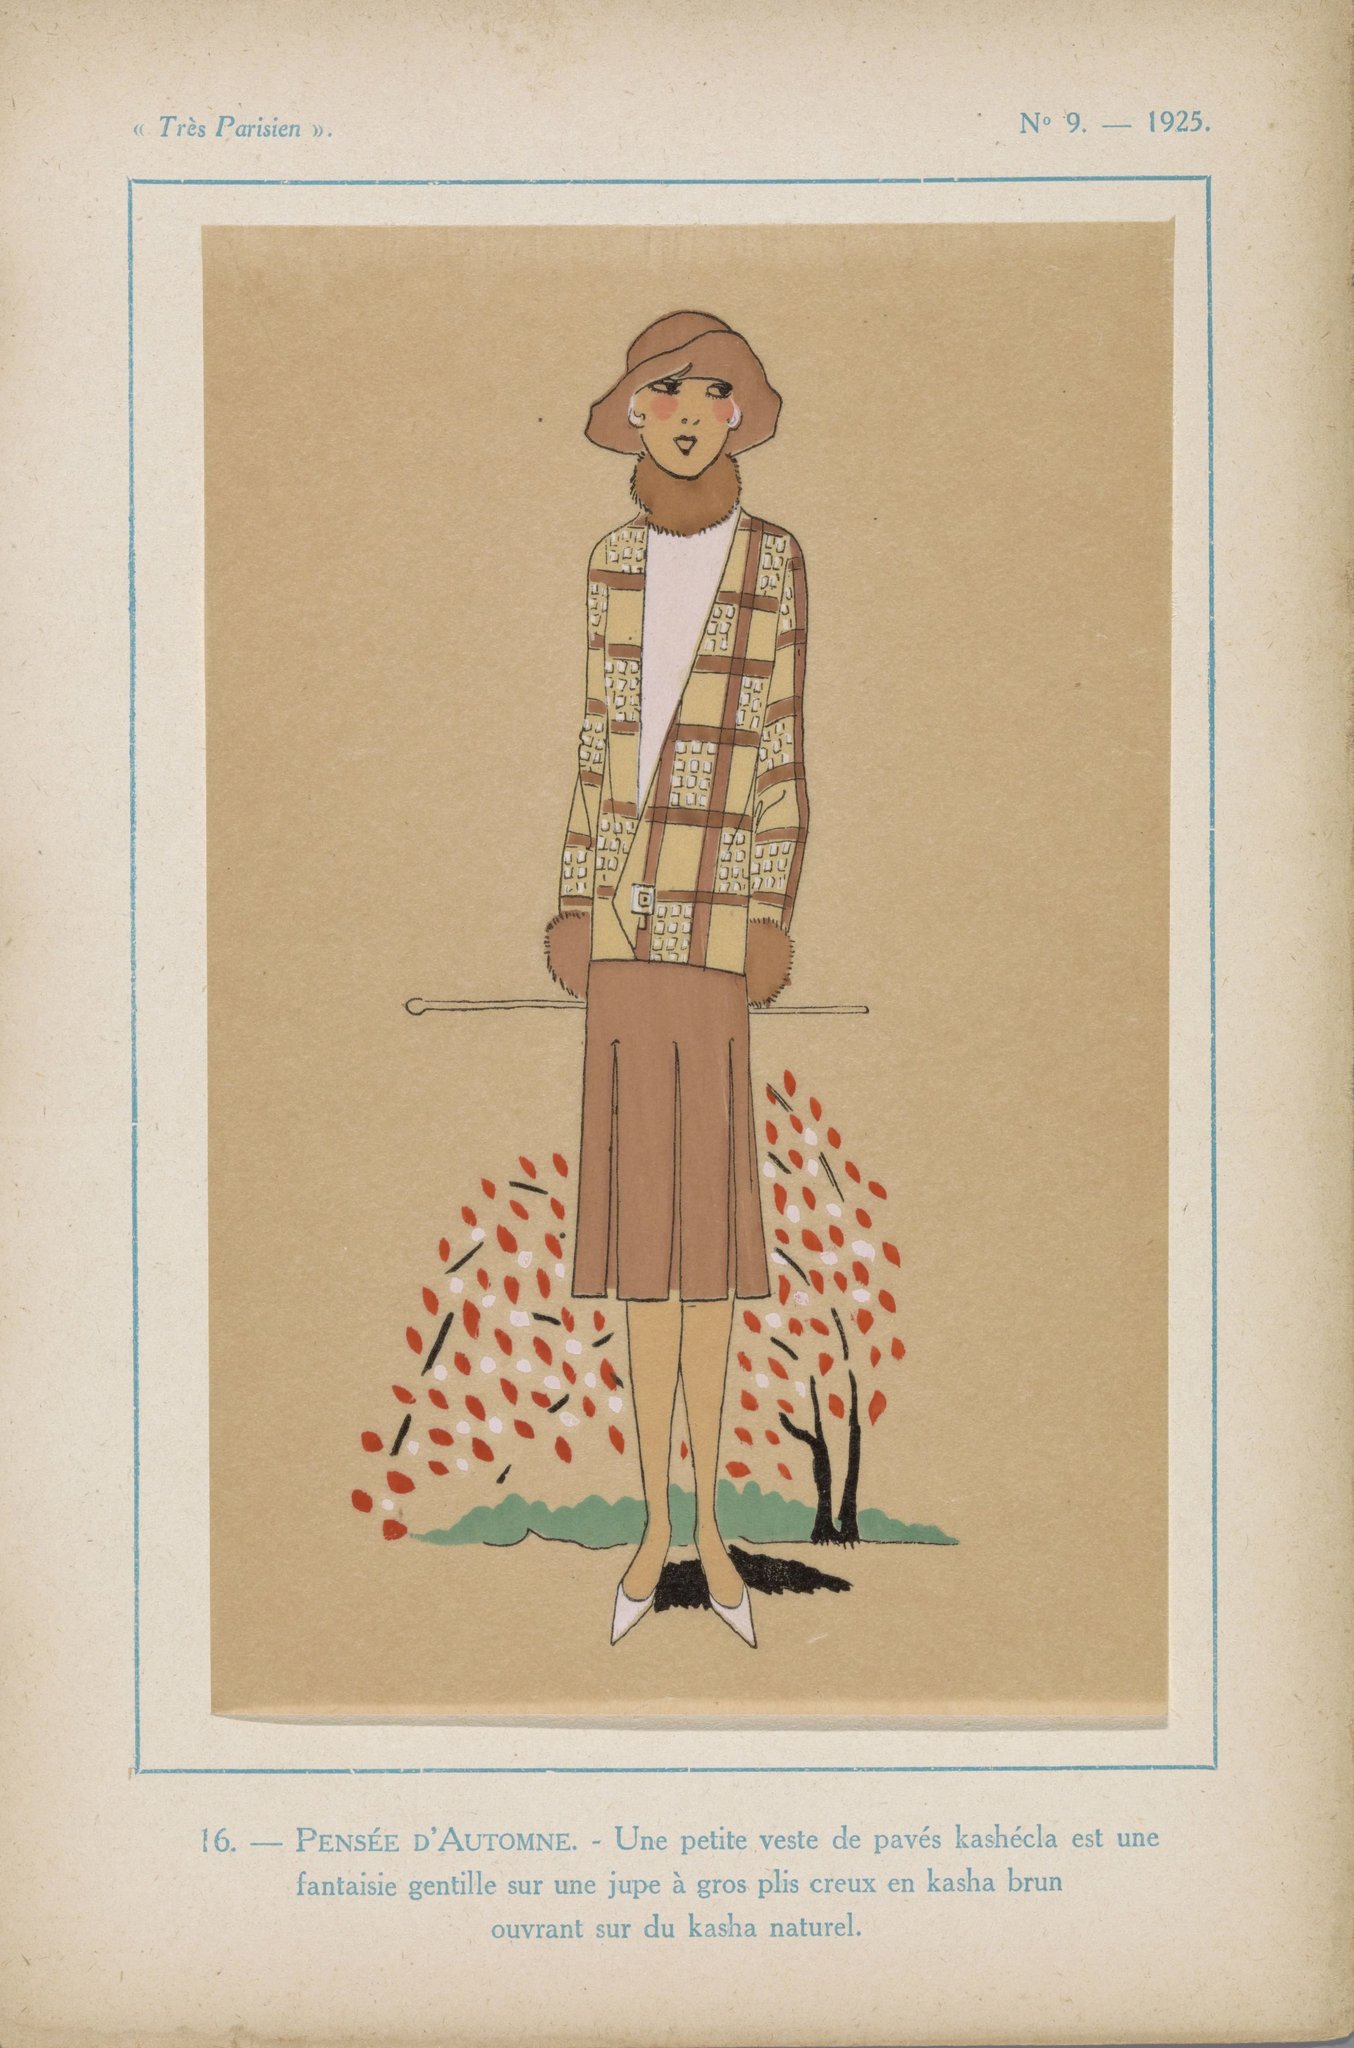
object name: fashion print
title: Très Parisien, 1925, No. 9, Pl. 16.- PENSÉE D'AUTOMNE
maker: g-p. joumard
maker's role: publisher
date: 1925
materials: paper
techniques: hand coloring, letterpress printing, lithography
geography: paris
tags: ensembles of pieces of clothing (three piece suit) (+ women's clothes), fashion plates, head-gear: hat (+ women's clothes)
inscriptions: caption: ‘16. - PENSÉE D'AUTOMNE. - Une petite veste de pavés kashécla est une fantaisie gentille sur une jupe à gros plis creux en kasha brun ouvrant sur du kasha naturel.’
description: Ensemble bestaand uit een vest, rok met dubbele plooien en een naturelkleurige trui. Prent uit het modetijdschrift Très Parisien...La Mode, Le Chic, L'Élégance (1920-1936)